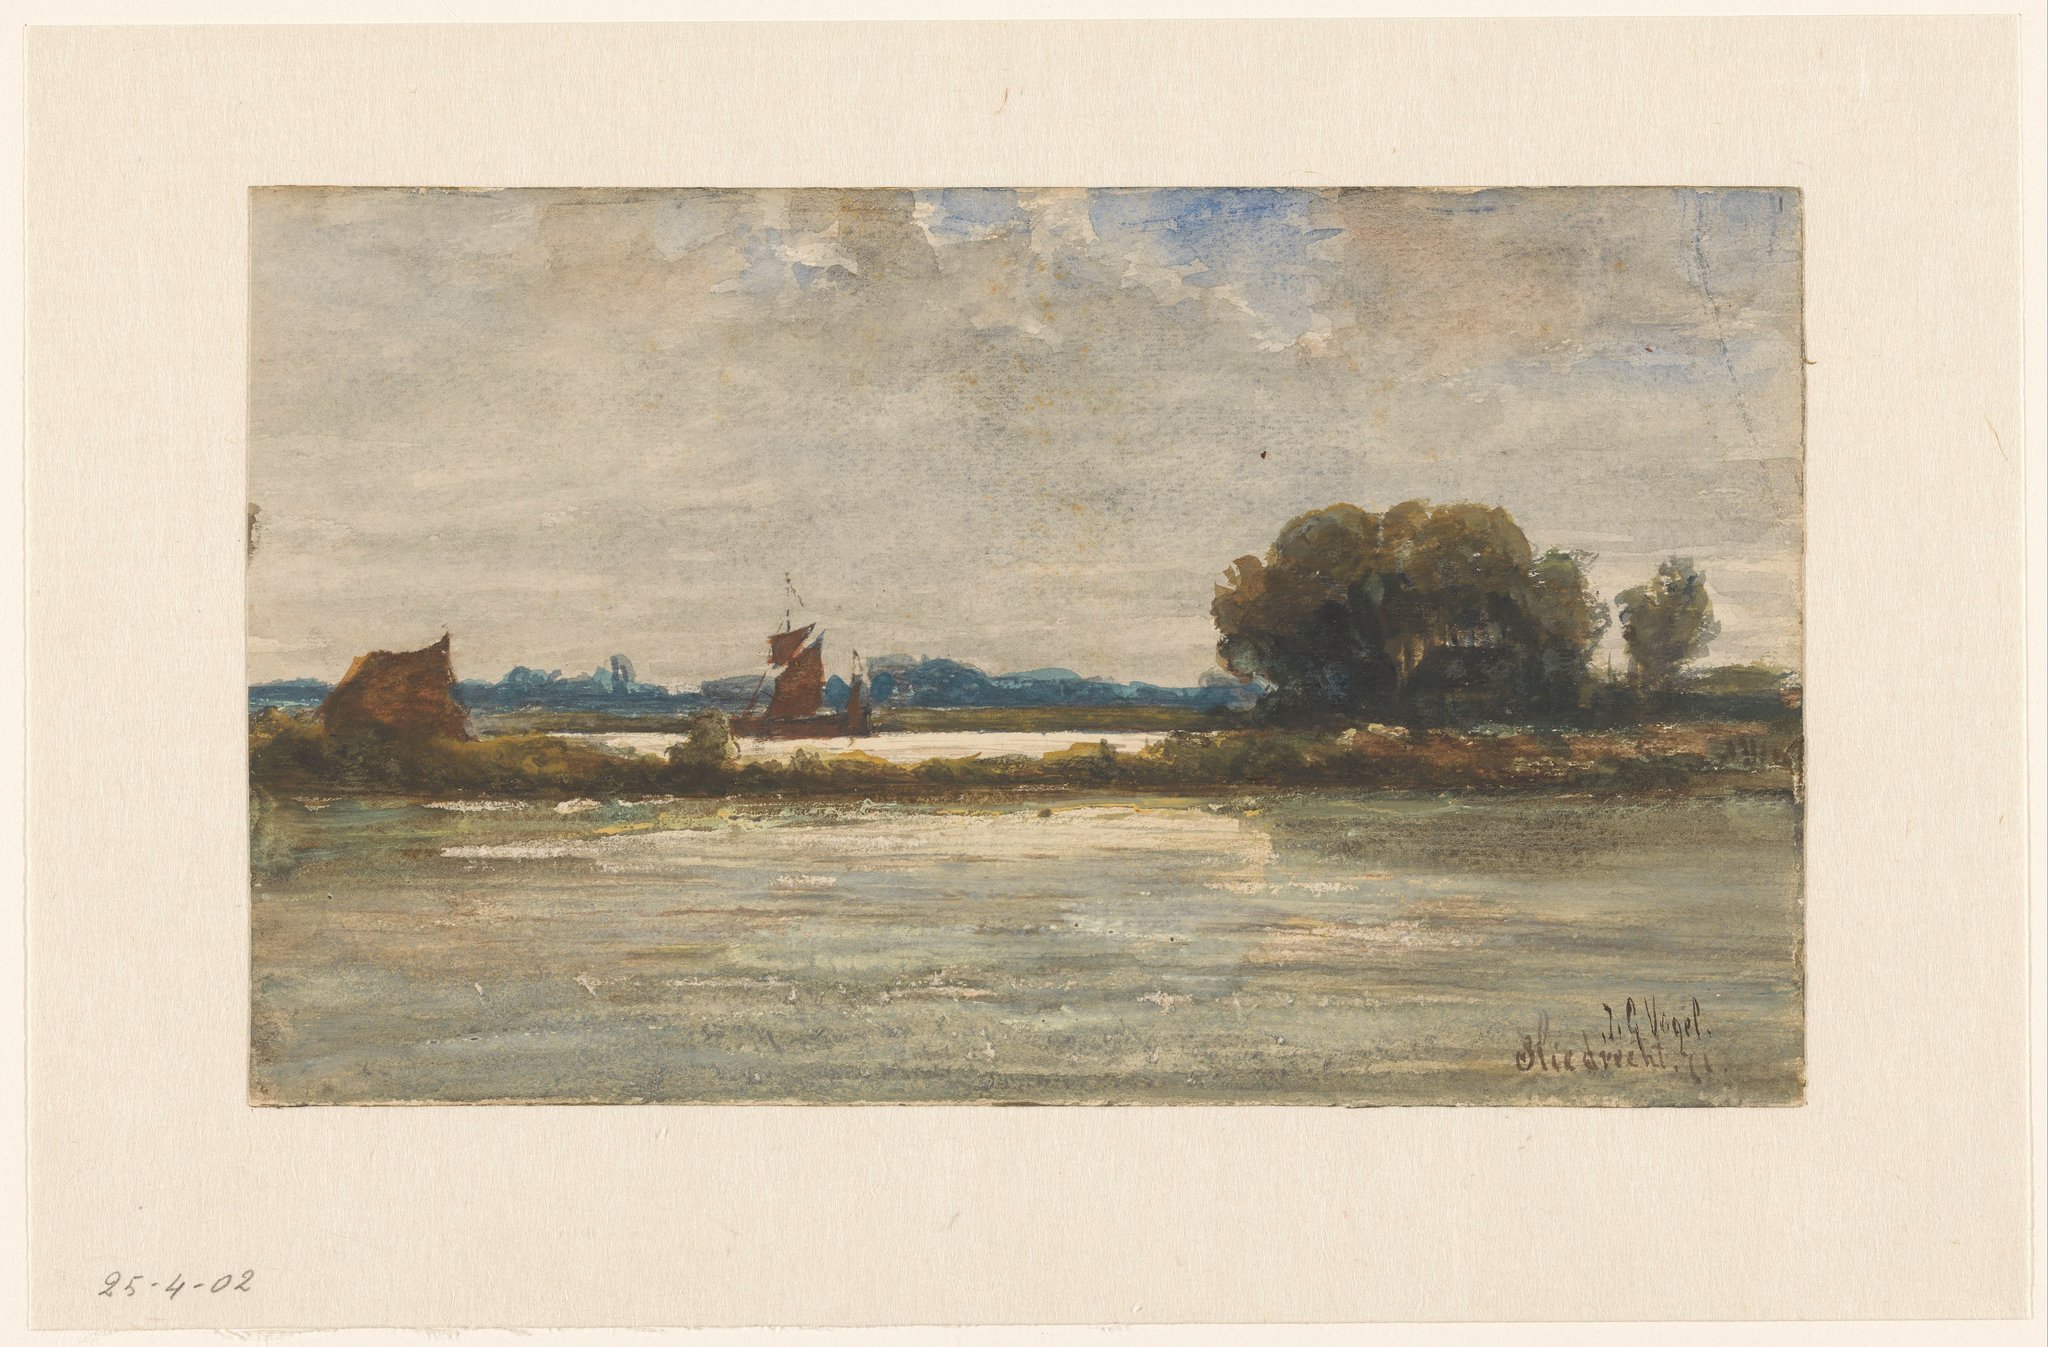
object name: drawing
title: Riviergezicht bij Sliedrecht met zeilschip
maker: johannes gijsbert vogel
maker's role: draughtsman, painter, print maker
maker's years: 1828-1915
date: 1871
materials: paper, watercolor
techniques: brush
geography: sliedrecht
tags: sailing-ship, sailing-boat, river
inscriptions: date